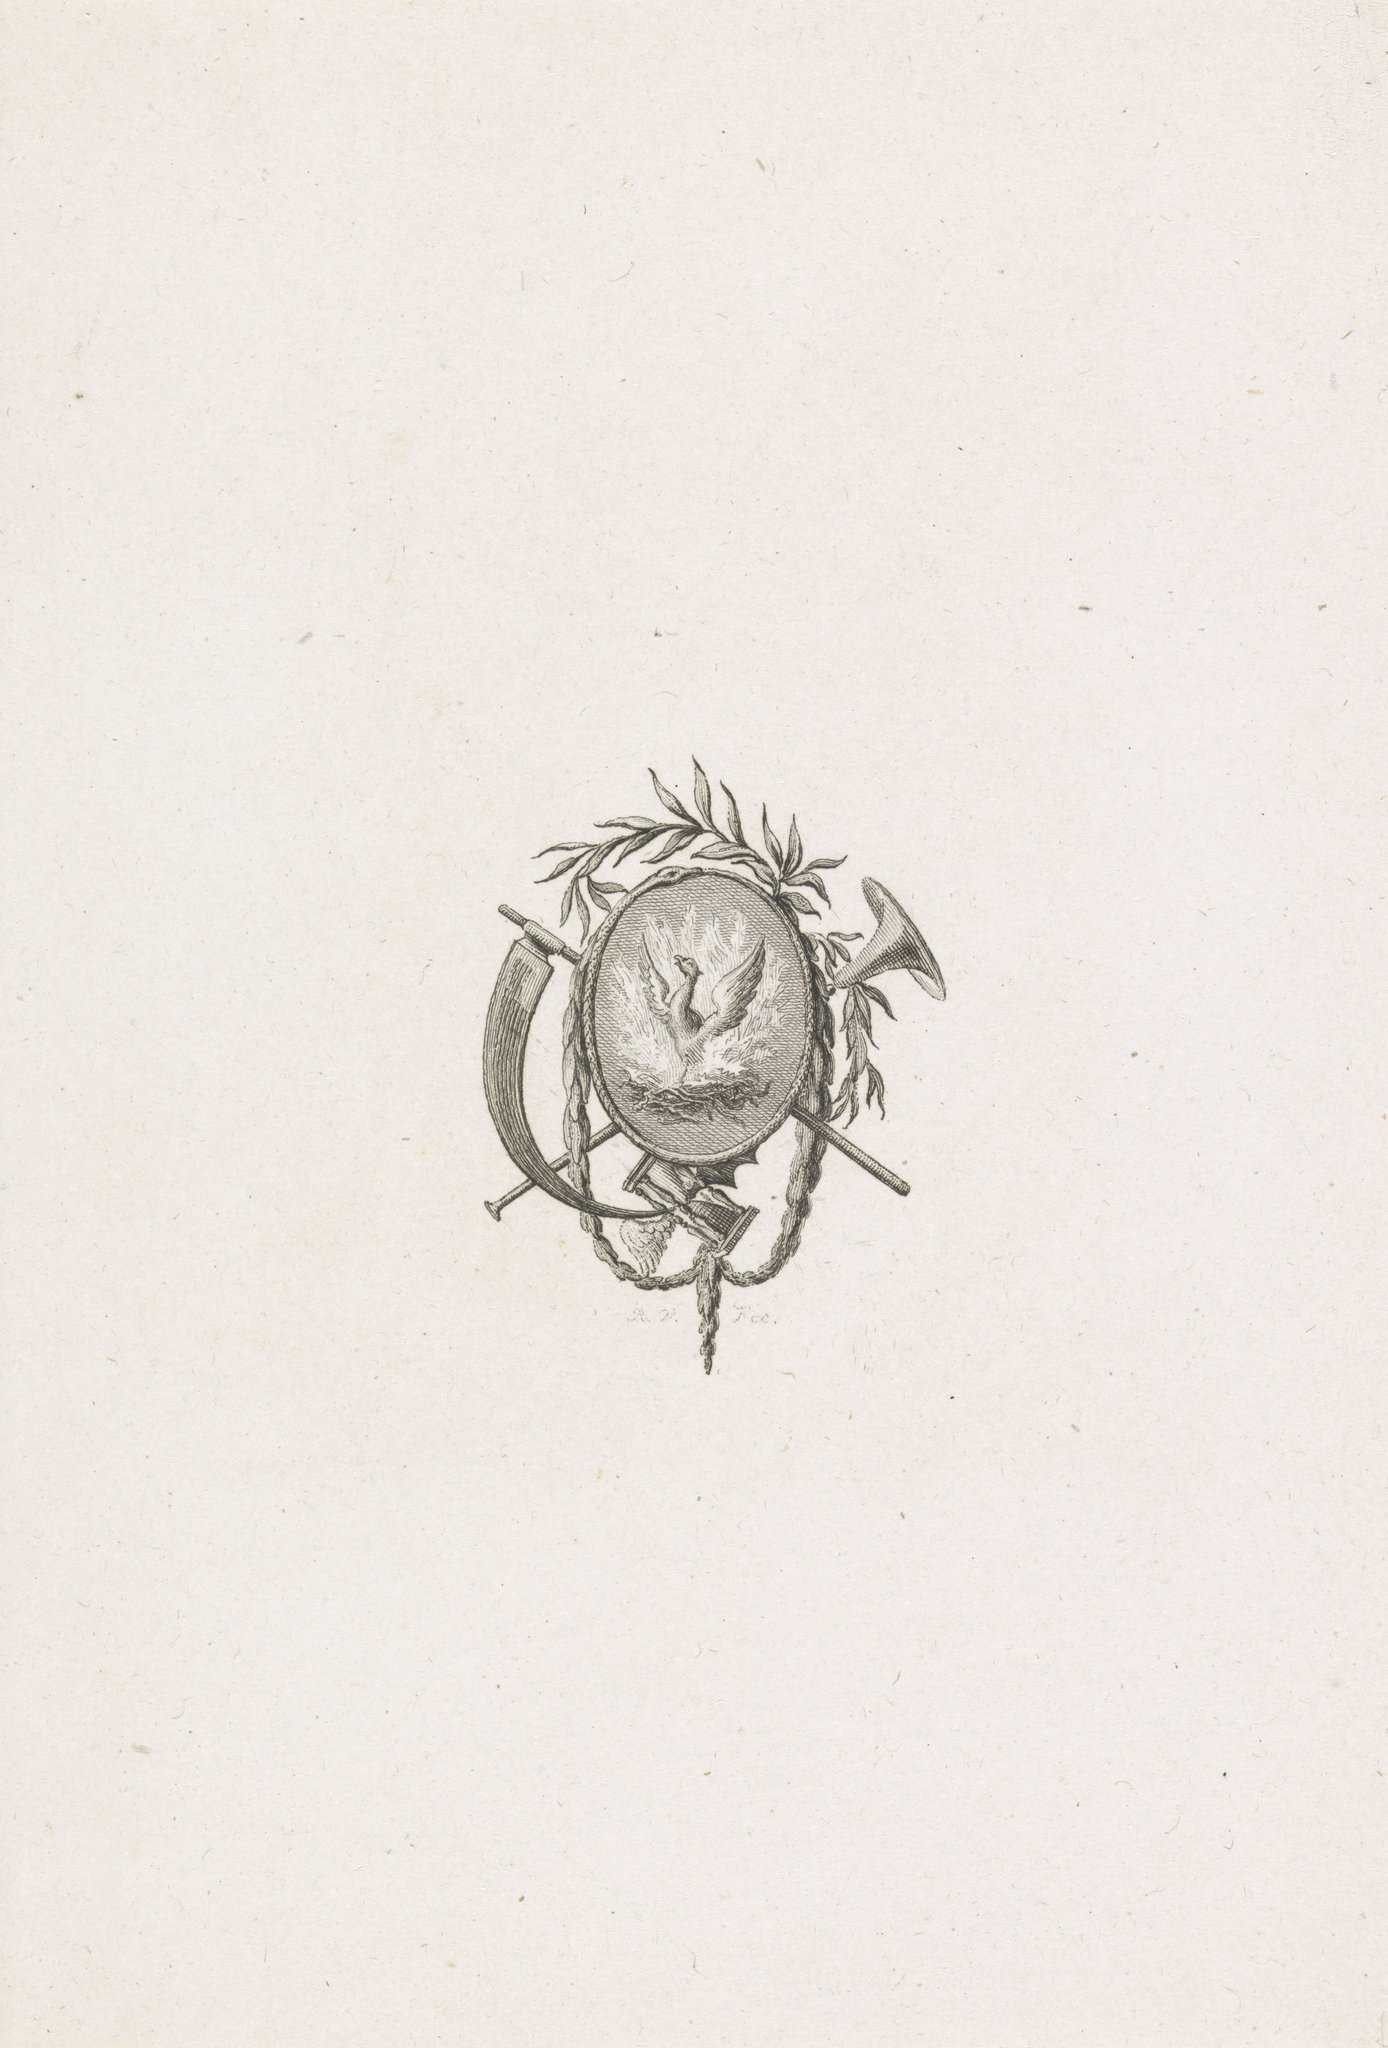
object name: print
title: Vignet met herrijzende fenix, 1806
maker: reinier vinkeles (i)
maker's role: draughtsman, print maker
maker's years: 1741-1816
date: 1806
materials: paper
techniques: engraving, etching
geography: netherlands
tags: william v (prince of orange), fabulous animals ~ birds: phoenix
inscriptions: collector's mark: Lugt 2228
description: Gebruikt als illustratie in: Jan le Francq van Berkhey, Lijkgedachtenis van zijne doorluchtige Hoogheid Prins Willem V, Amsterdam: Johannes Allart, 1806. Niet in Frederik Muller; door het RPK toegevoegd nummer.